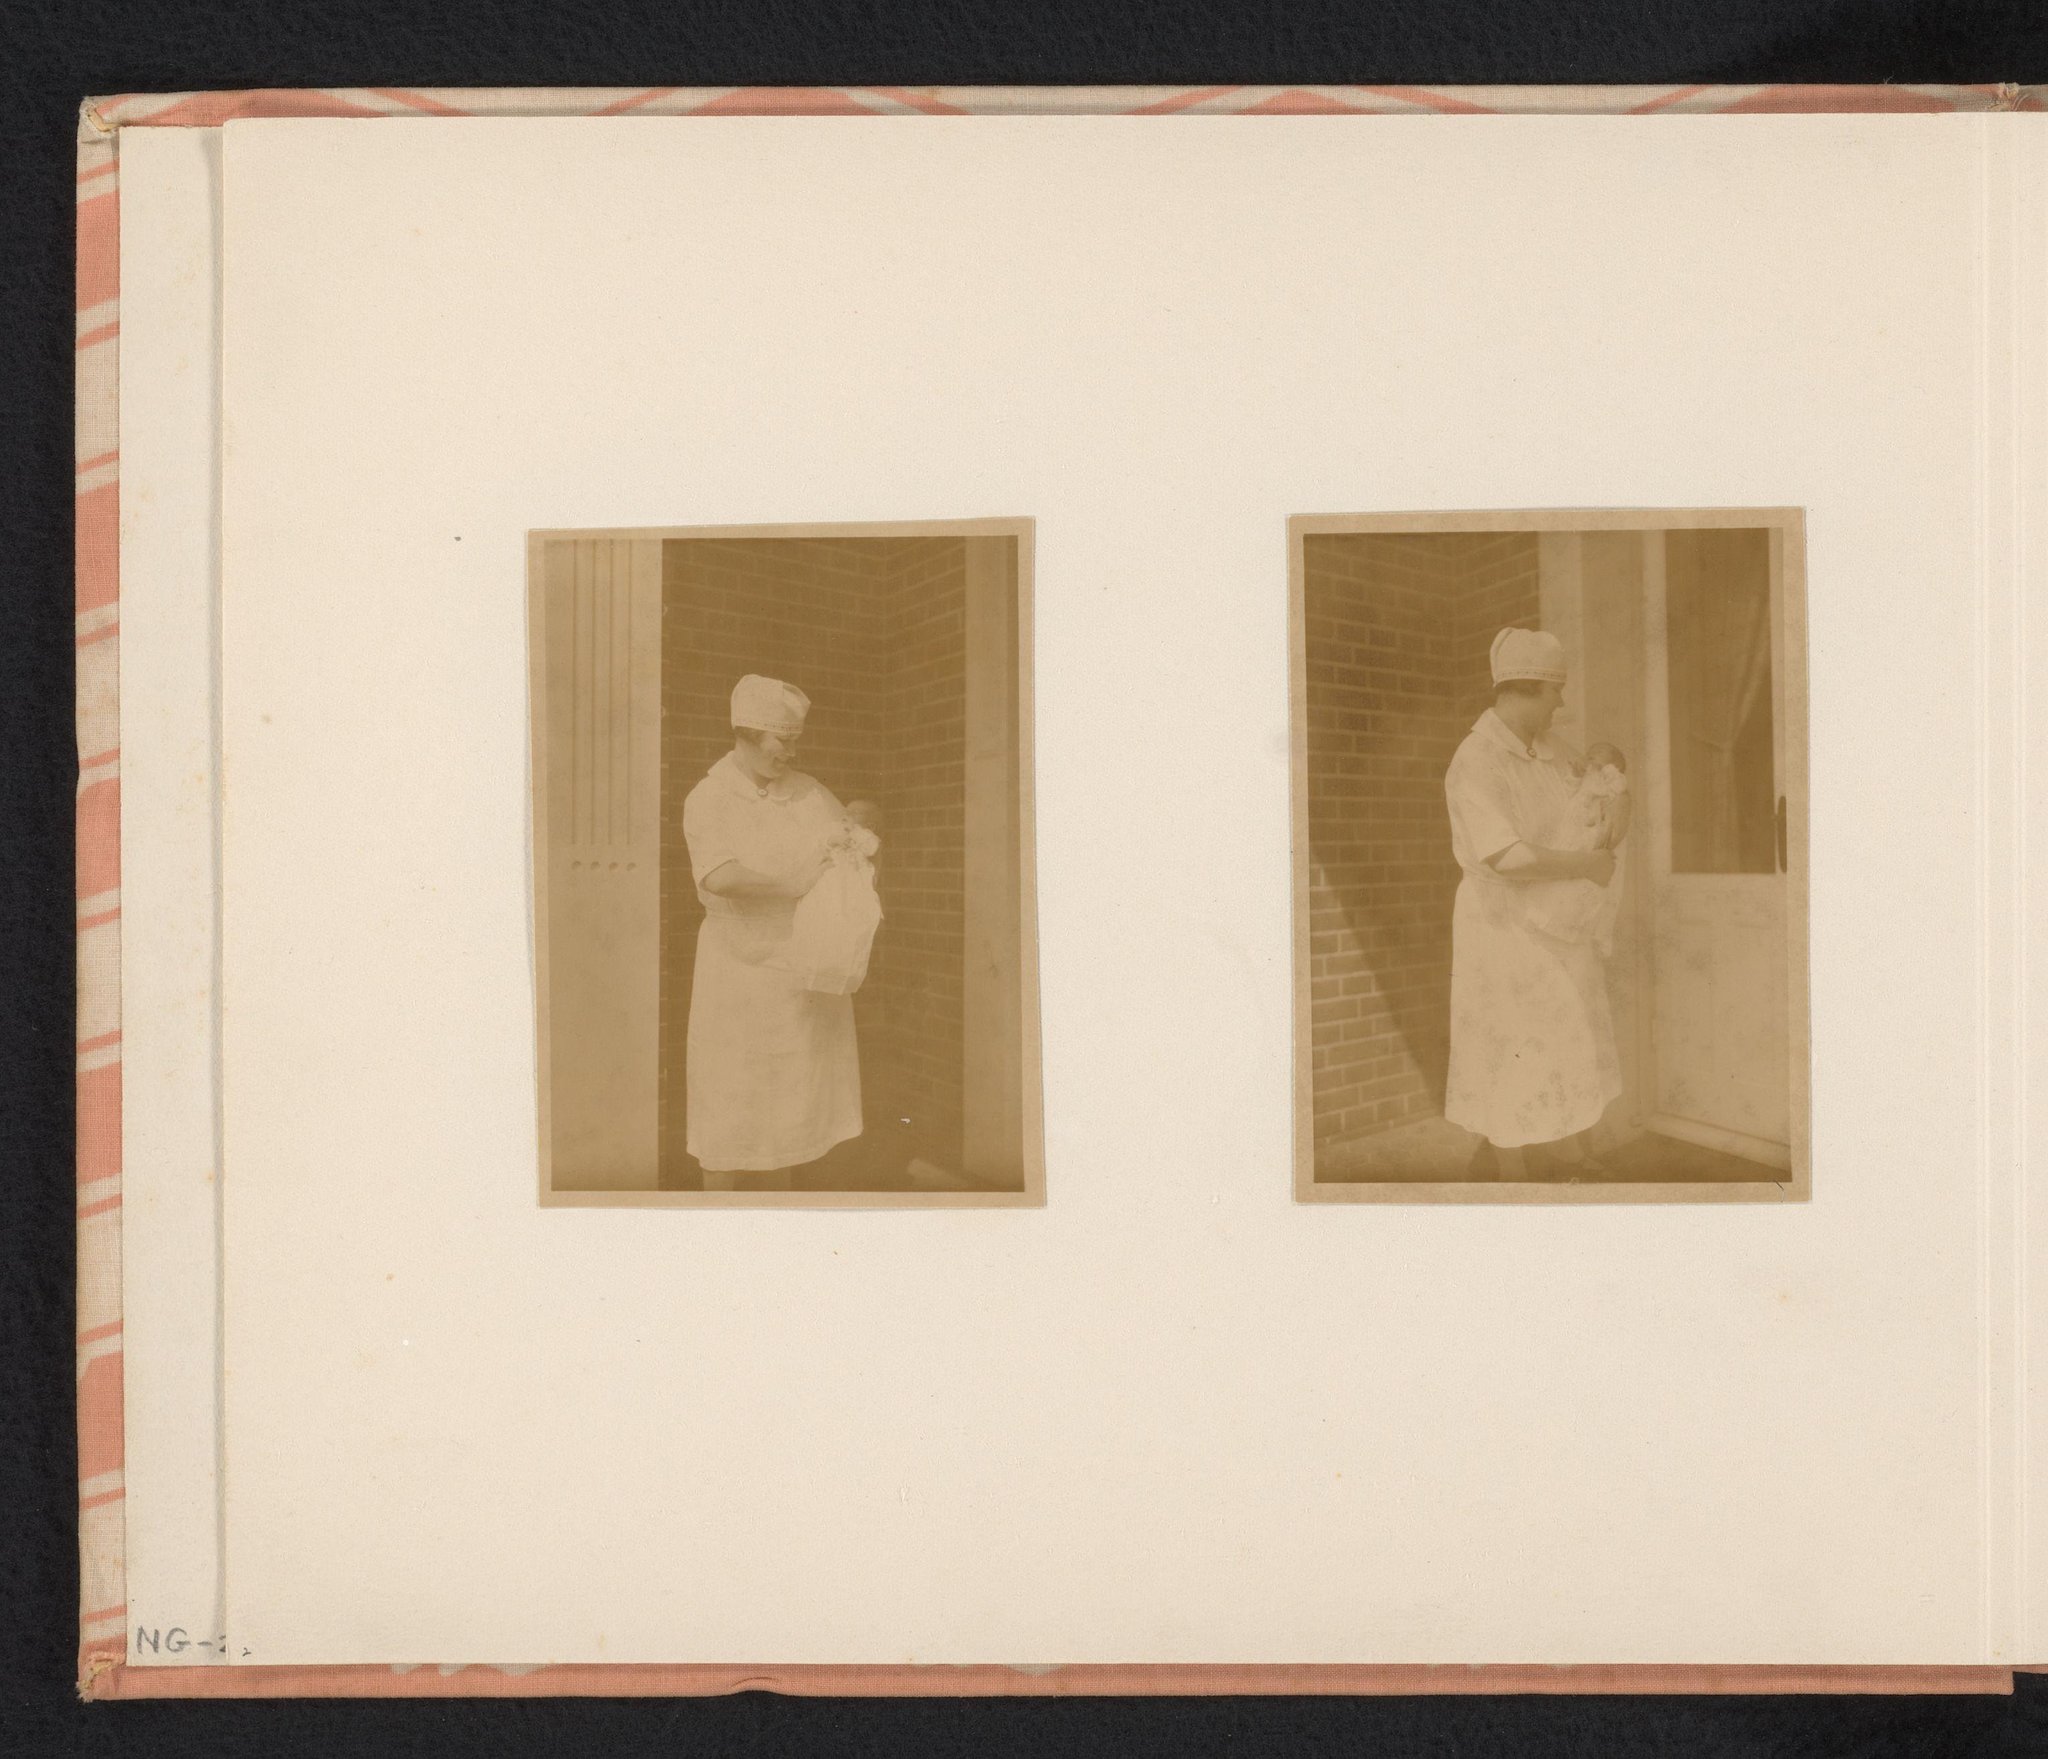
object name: photograph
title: Isabel Wachenheimer als pasgeboren baby in de armen van een onbekende verpleegster, juni-juli 1928, Hamburg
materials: photographic support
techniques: gelatin silver print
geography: hamburg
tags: leiden, isabel wachenheimer-elon, family life at home, infant, baby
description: Albumblad met twee foto's met Isabel Wachenheimer (rechts) en onbekende verpleegster (links). Onderdeel van het fotoalbum met foto's van Isabel Wachenheimer als kind (1928-1931).